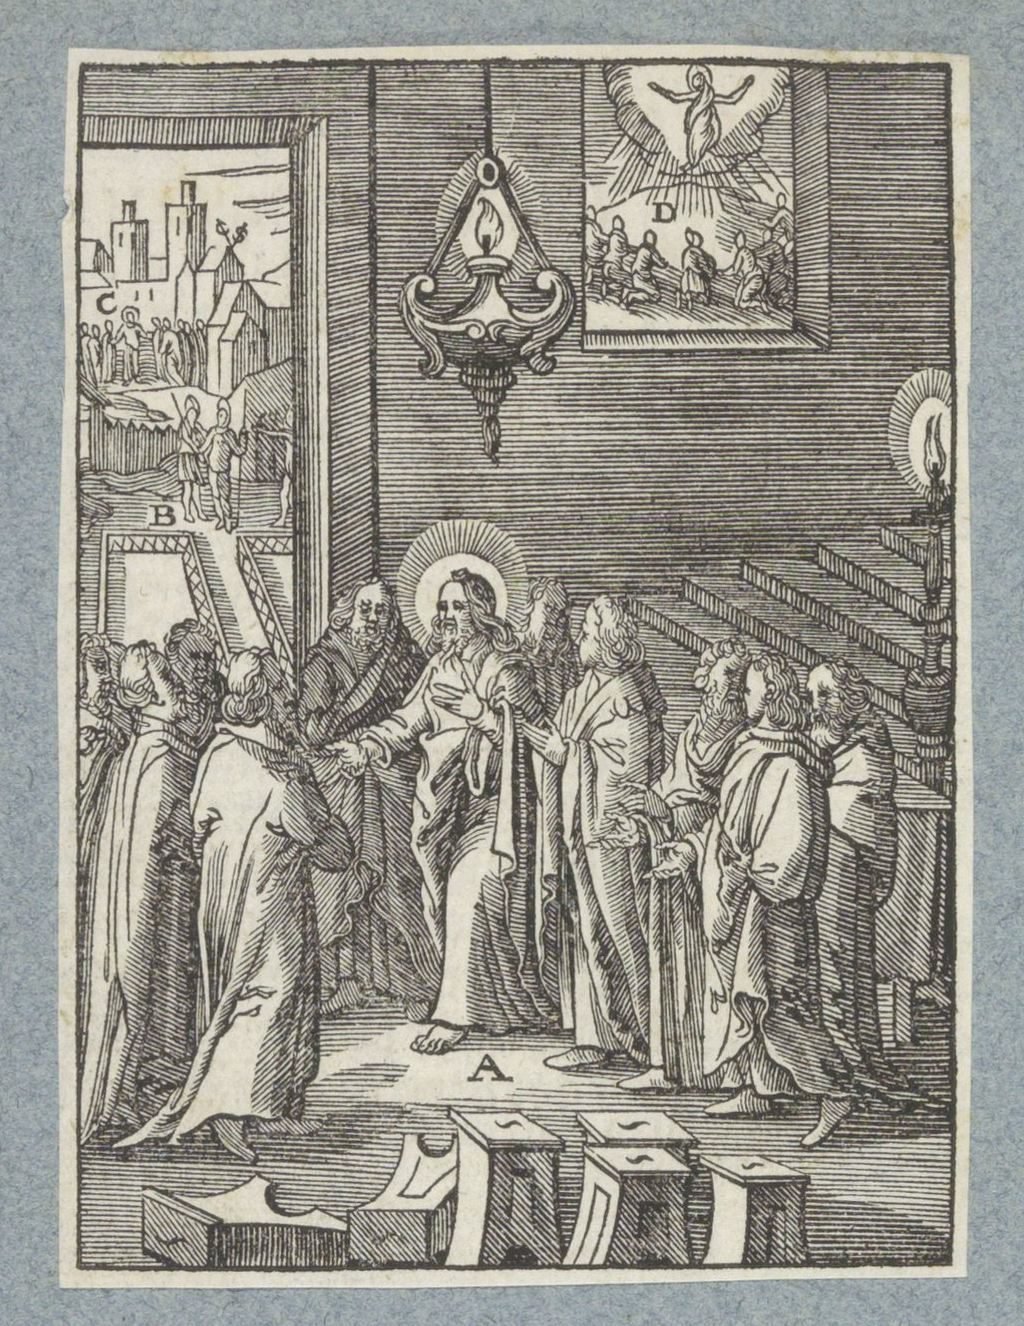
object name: book illustration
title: Christus voorspelt zijn dood en opstanding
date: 1629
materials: paper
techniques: letterpress printing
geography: amsterdam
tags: events just before the resurrection, resurrection of christ, christ foretelling his passion (at various occasions) (matthew 16:21, 17:22-23; mark 8:32, 9:31; luke 9:22, 9:44)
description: De prent is afkomstig uit een van de uitgaven van P.J. Paets uit Amsterdam. De prent wordt voor het eerst gebruikt in: Der Zielen Lust-hof. Leuven, I.Jacbosz voor P.J. Paets [= Amsterdam, P.J. Paets], 1629. De voorstelling is gekopieerd naar een prent van Hieronymus Wierix voor: Nadal, Jerónimo. Evangelicae Historiae Imagines. Antwerpen, M. Nutius, 1593.